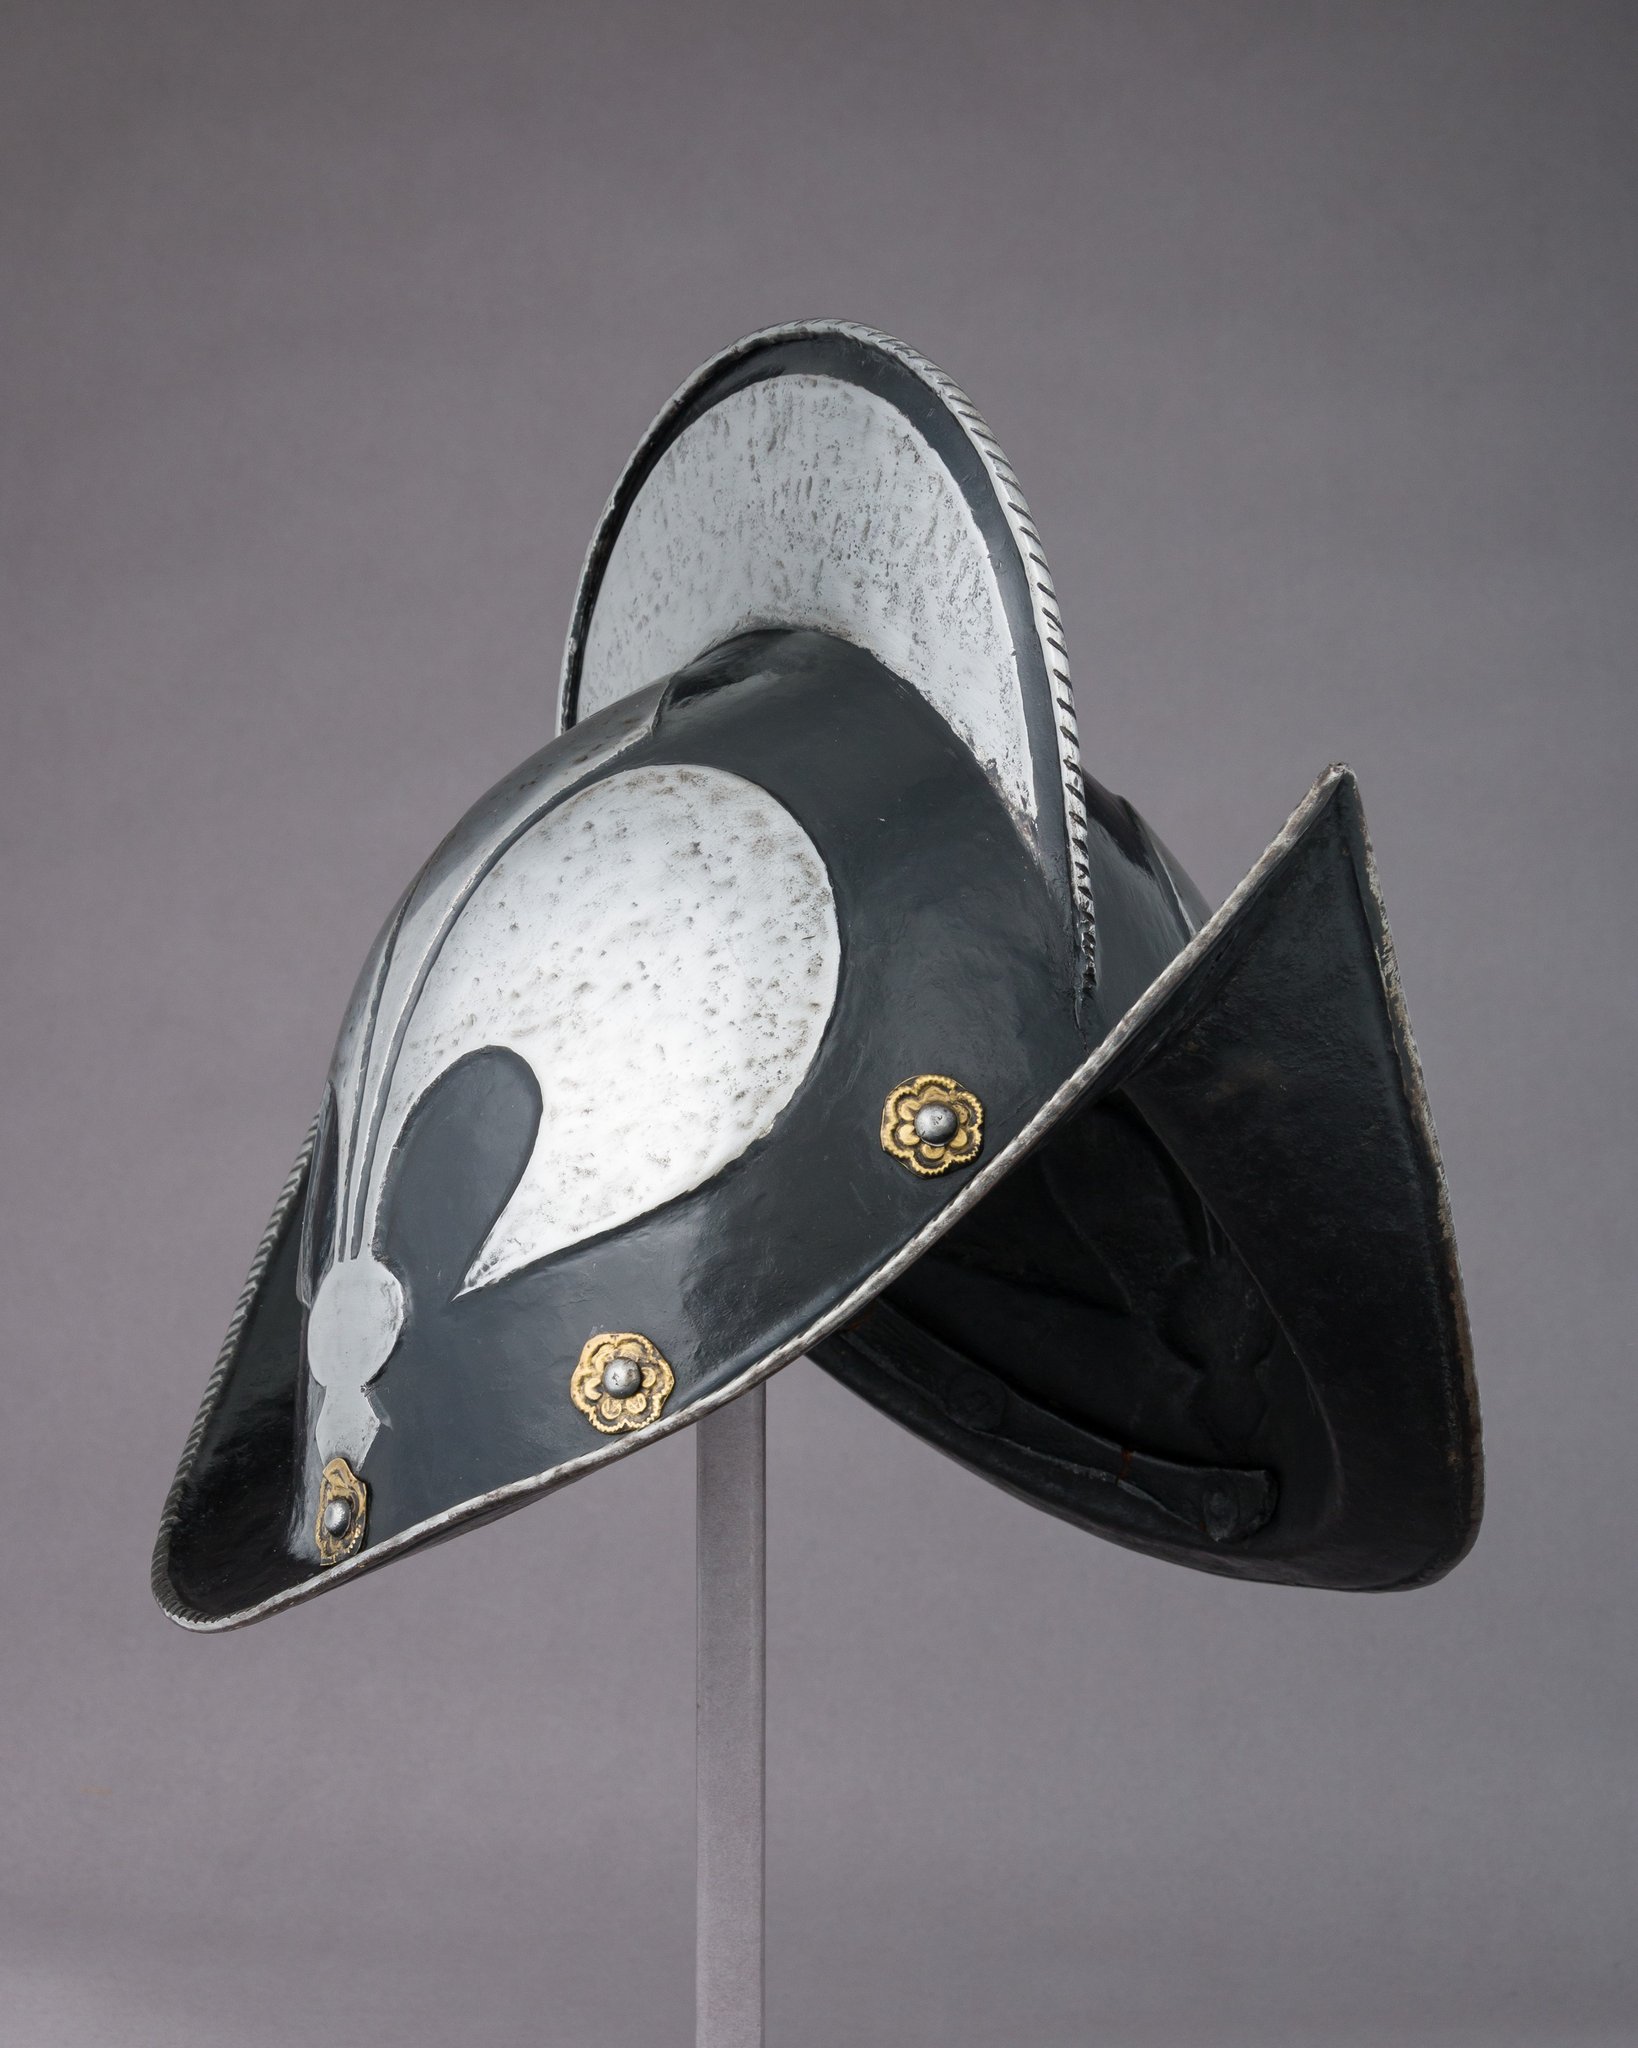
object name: morion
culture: german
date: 1501-1600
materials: copper alloy, steel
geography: germany